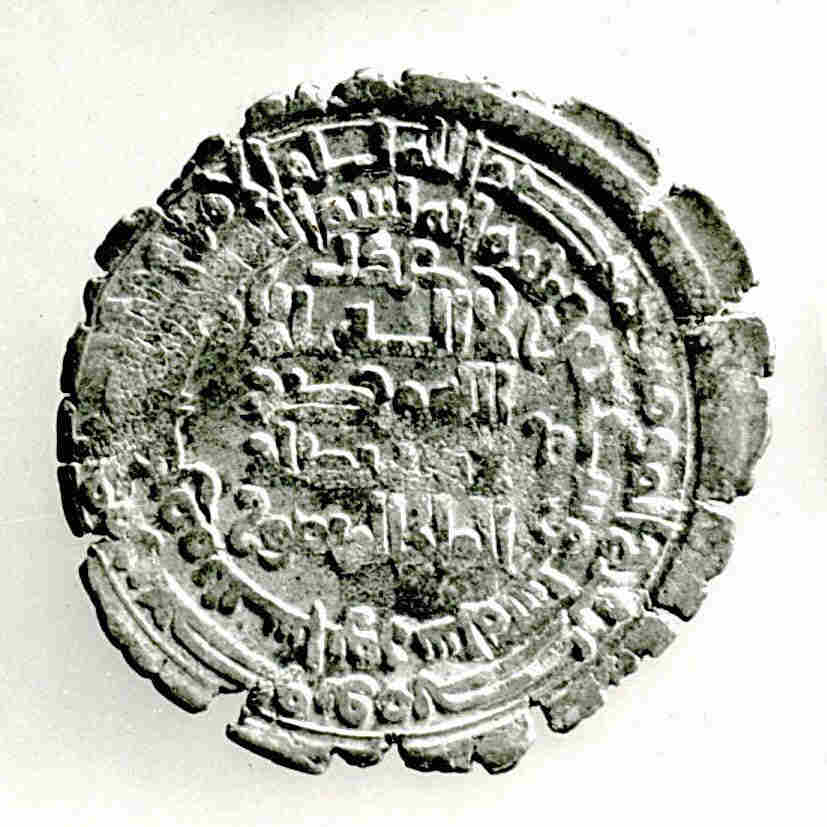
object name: coin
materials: silver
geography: iran